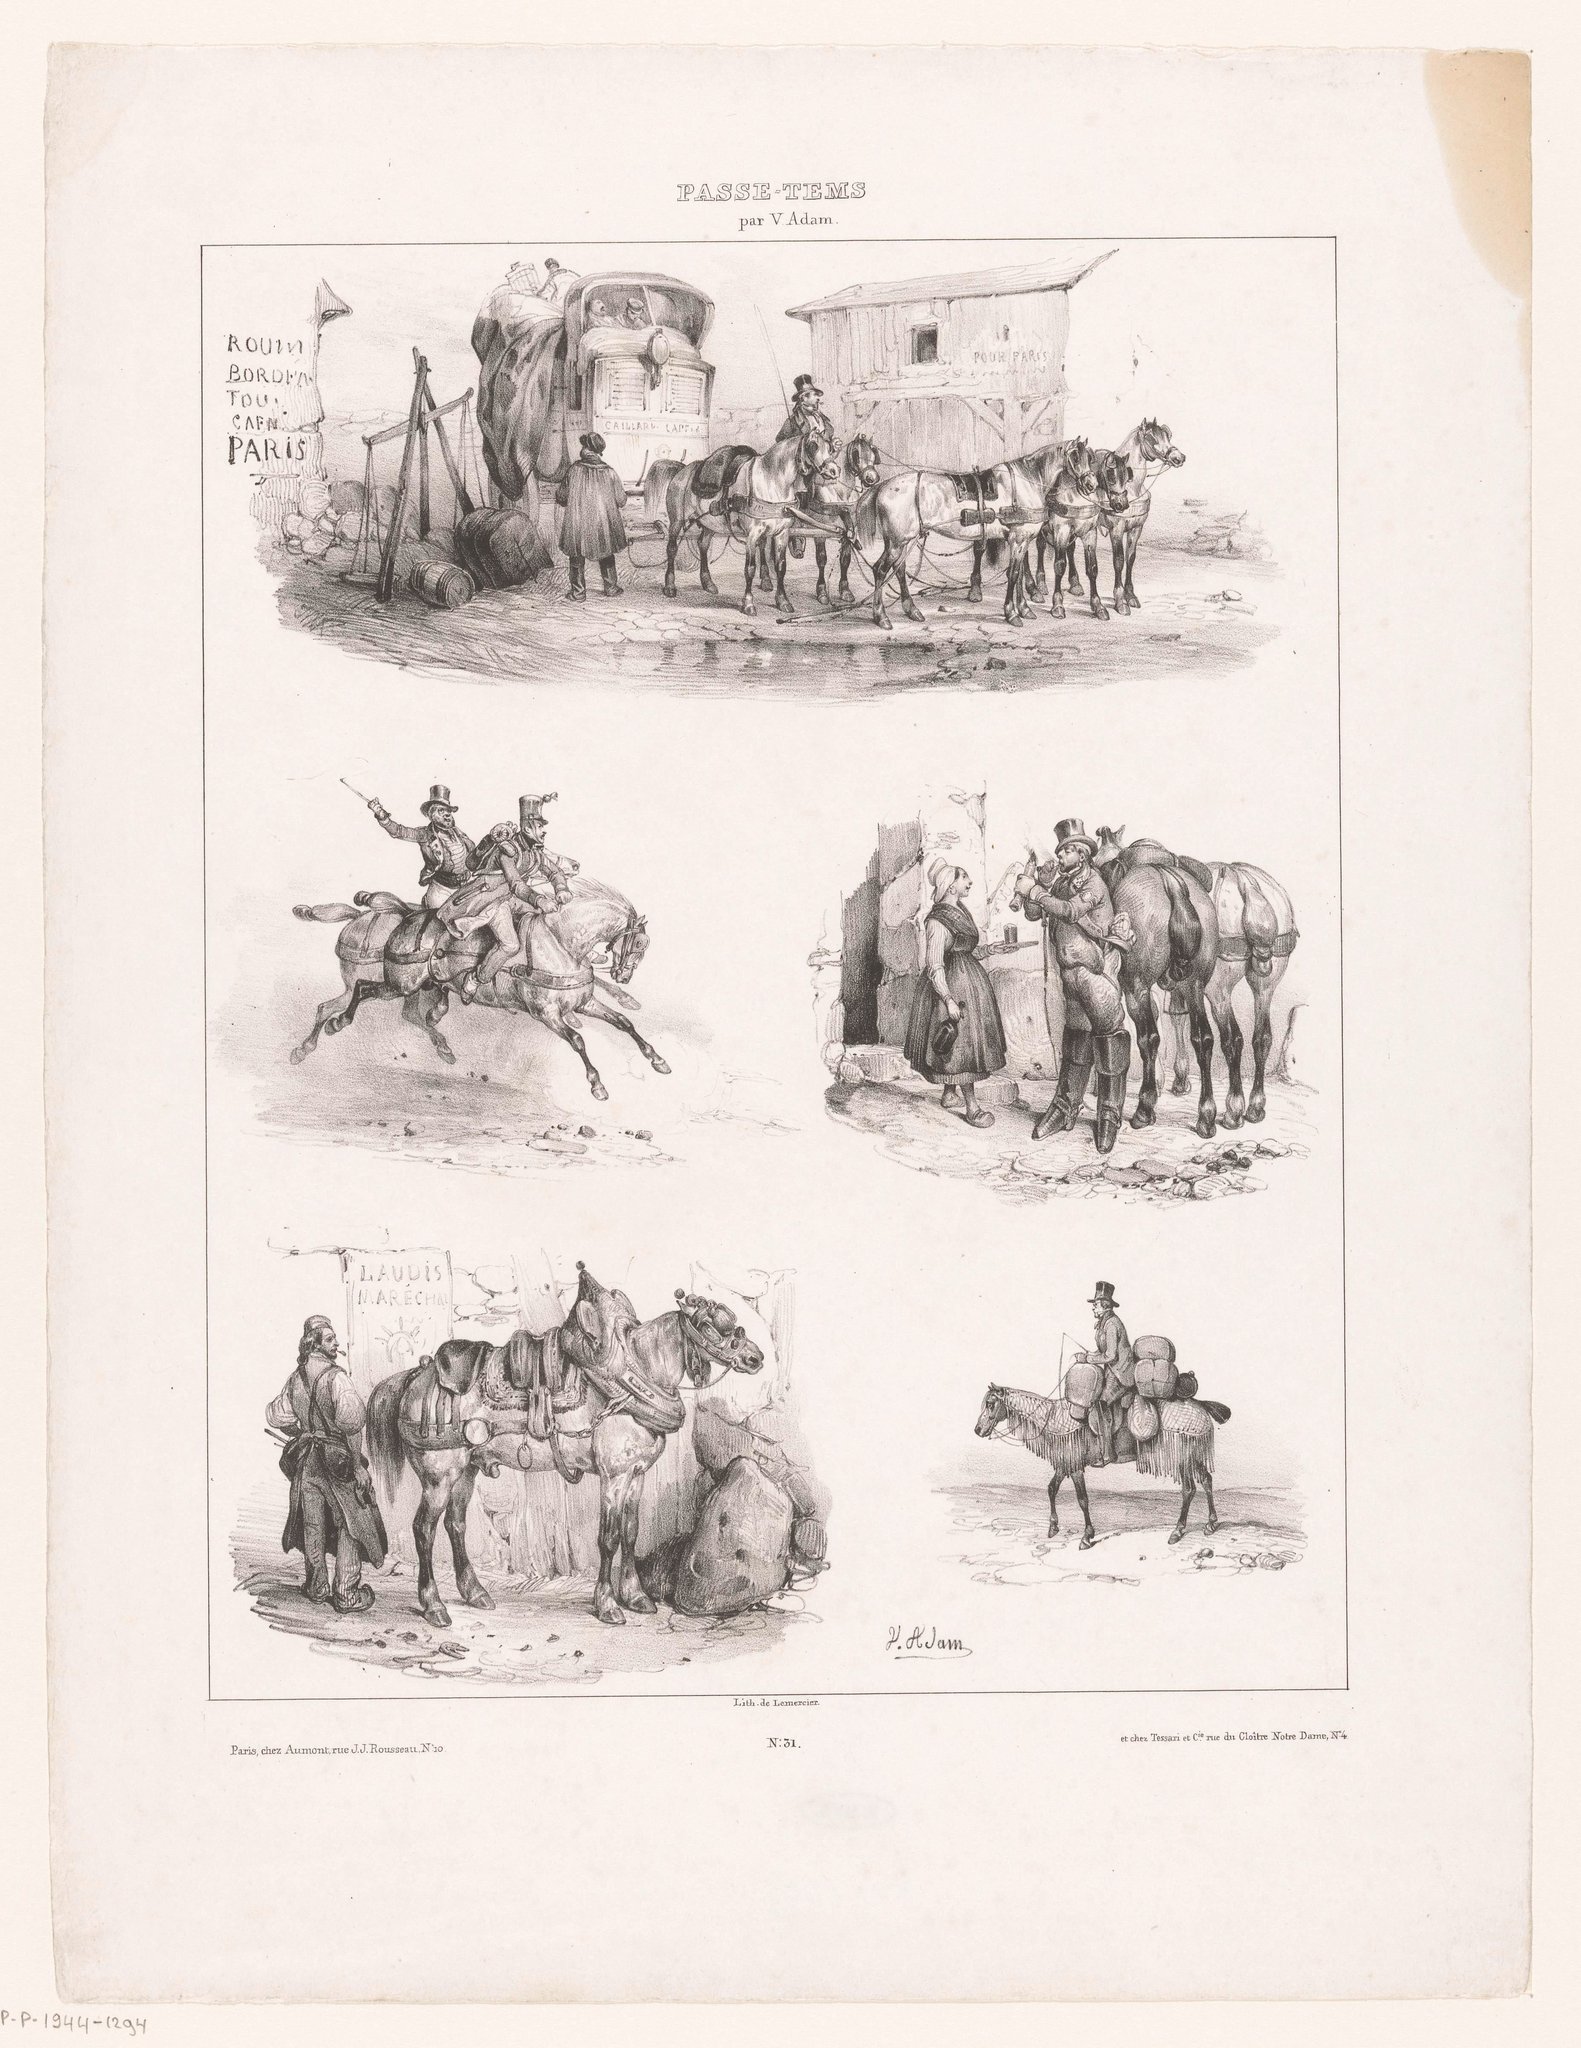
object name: print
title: Passe-tems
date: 1833-1837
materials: paper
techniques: lithography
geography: paris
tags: recreation, amusement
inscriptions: collector's mark: Lugt 2228